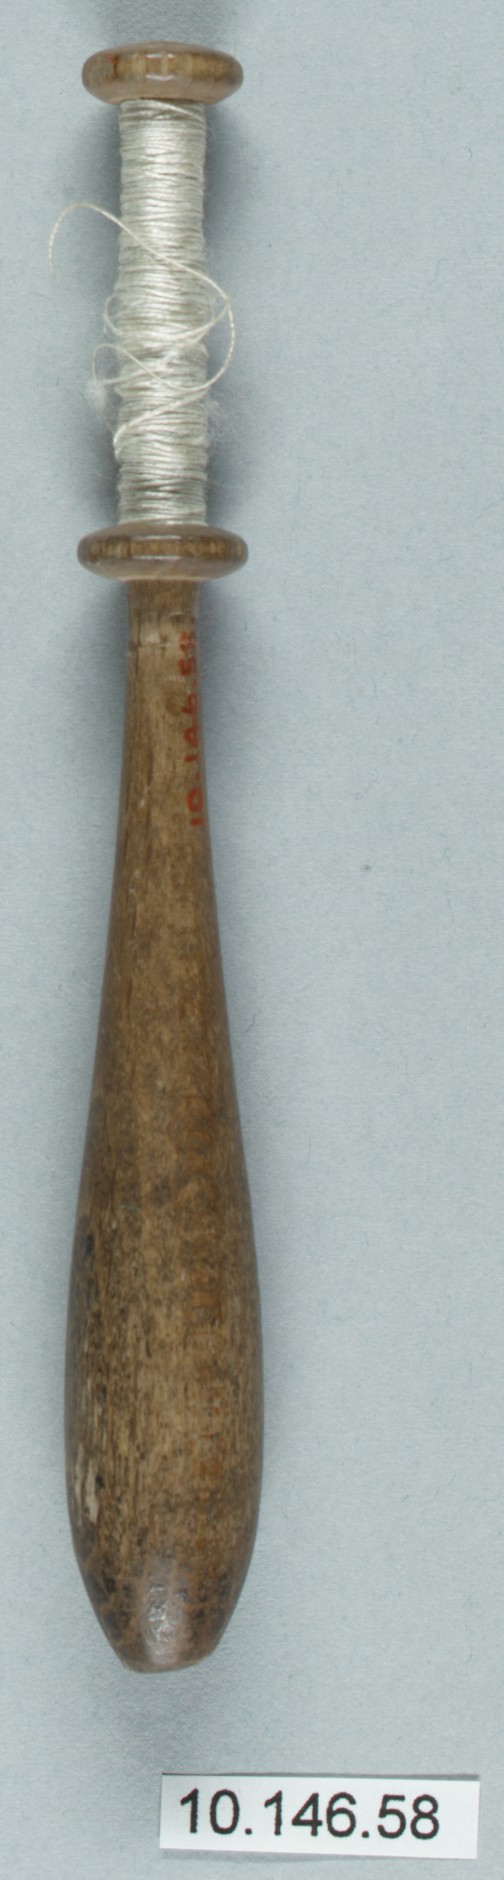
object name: bobbin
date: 1701-1800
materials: wood